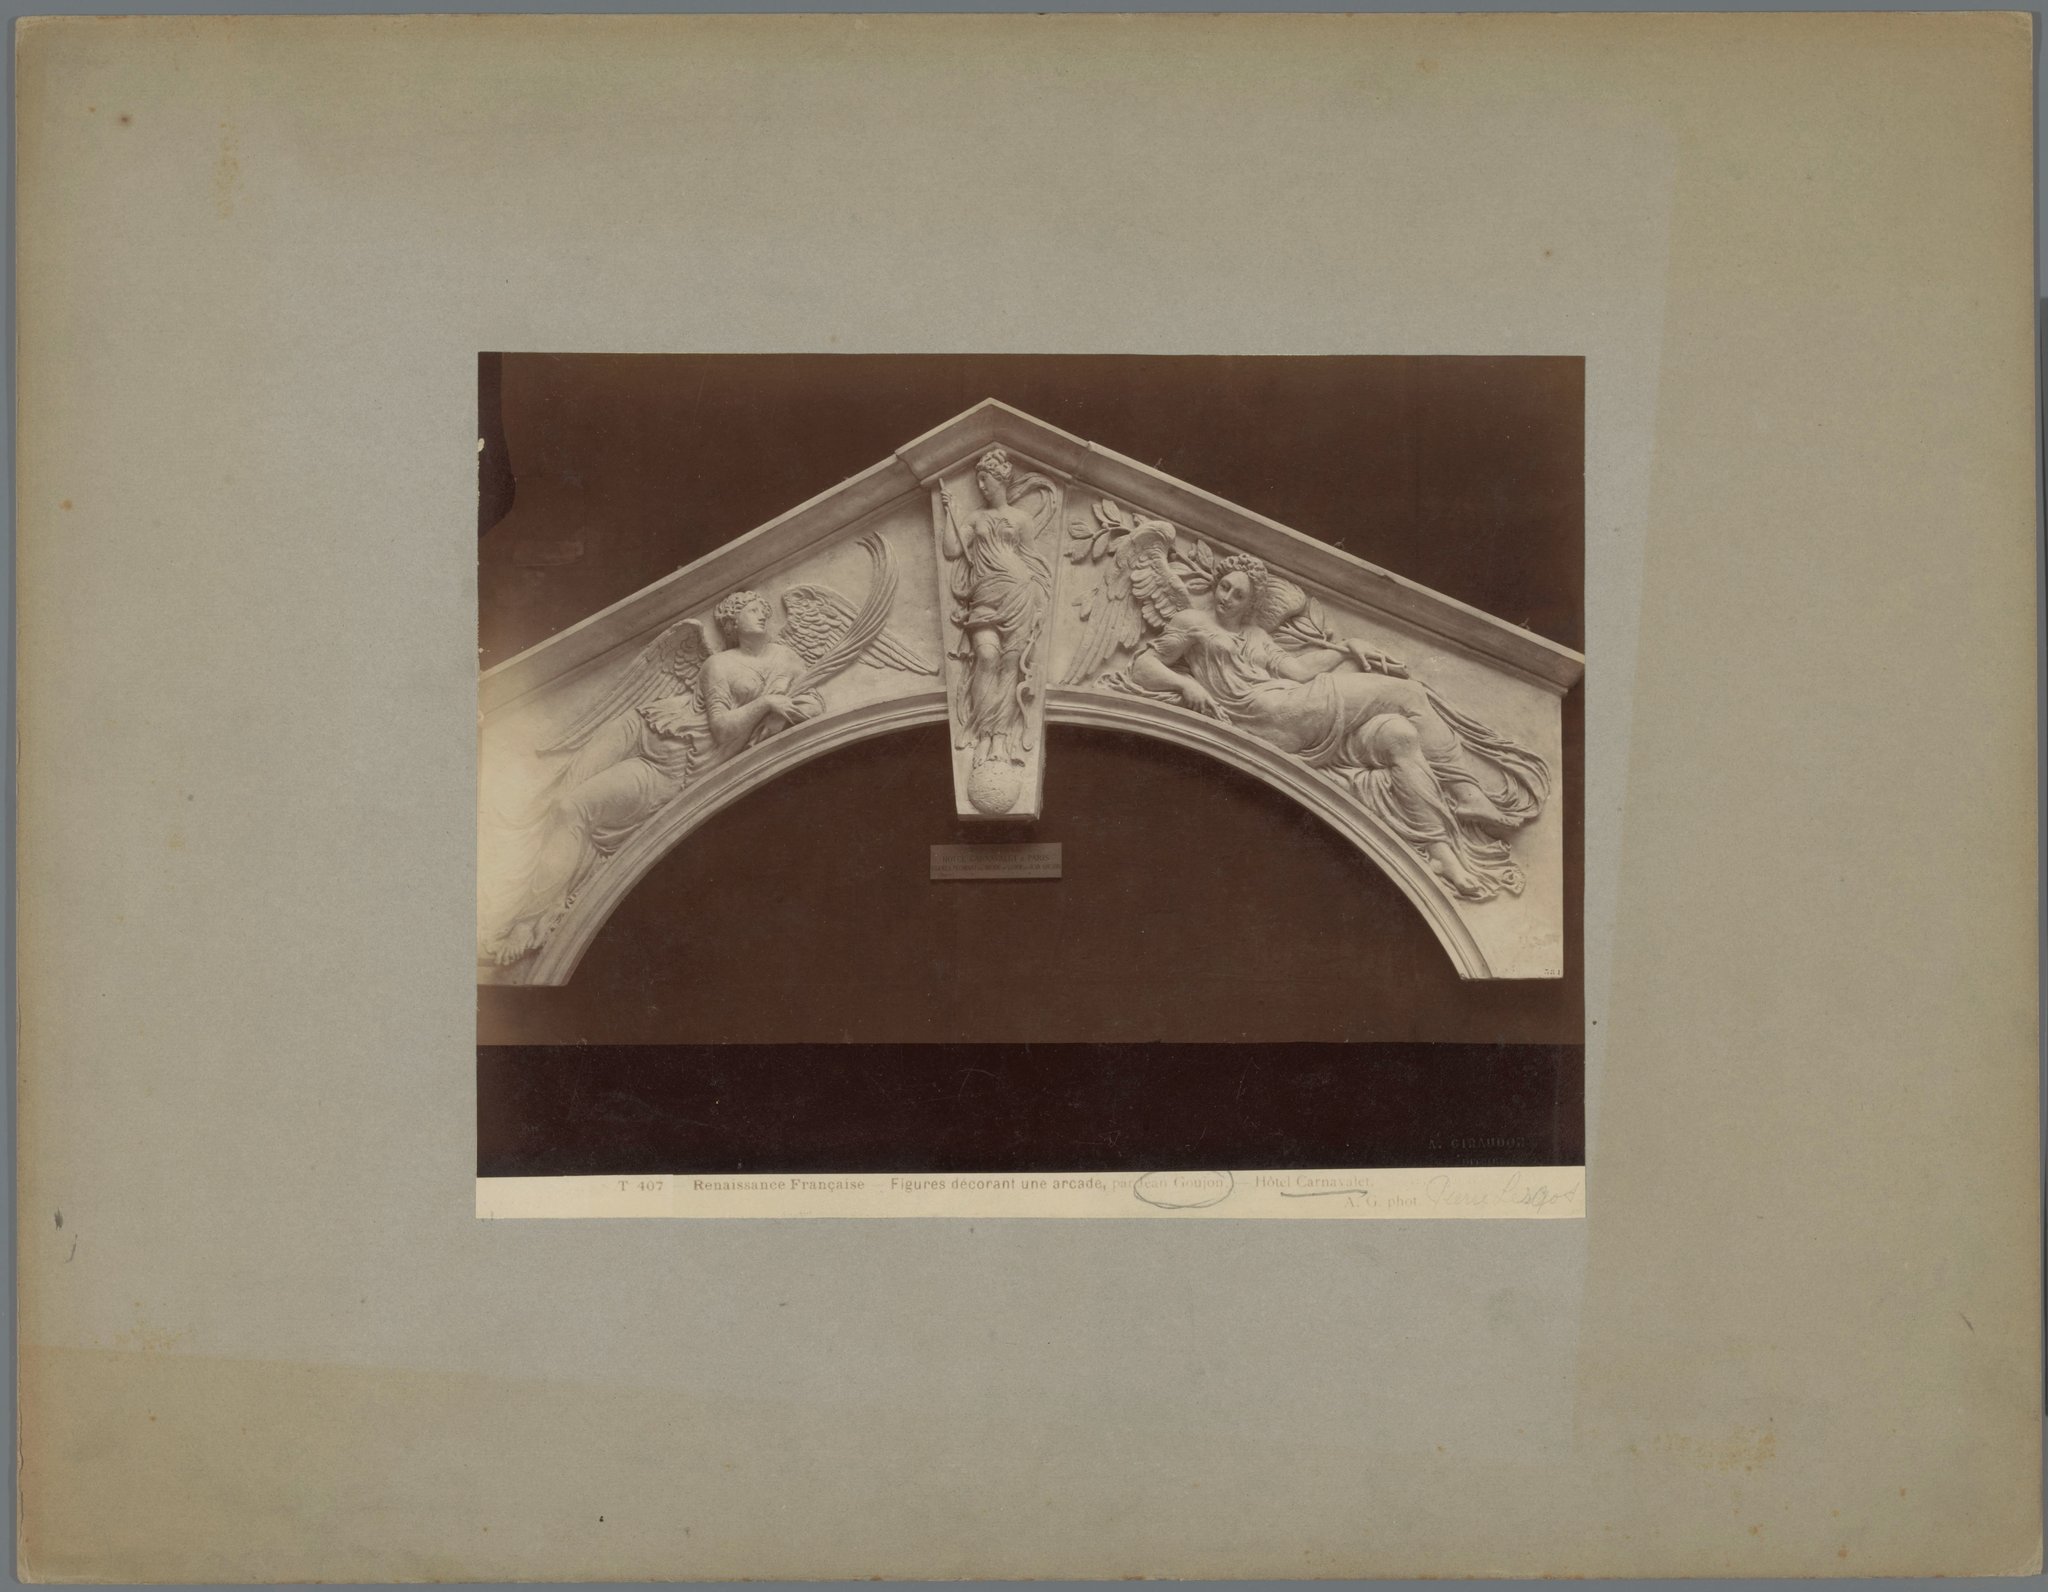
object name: photograph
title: Hek voor een kapel van de kathedraal de Notre-Dame te Évreux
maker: adolphe giraudon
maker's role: publisher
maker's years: 1849-1929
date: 1875-1900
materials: cardboard, photographic support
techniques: albumen print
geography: paris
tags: fence, wall, paling, parts of church interior: chapel, sculpture (+ relief ~ sculpture)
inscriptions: name: ‘A. GIRAUDON EDITEUR 15. R. BONAPARTE PARIS’, collector's mark: Lugt 3937, number: ‘T 466’